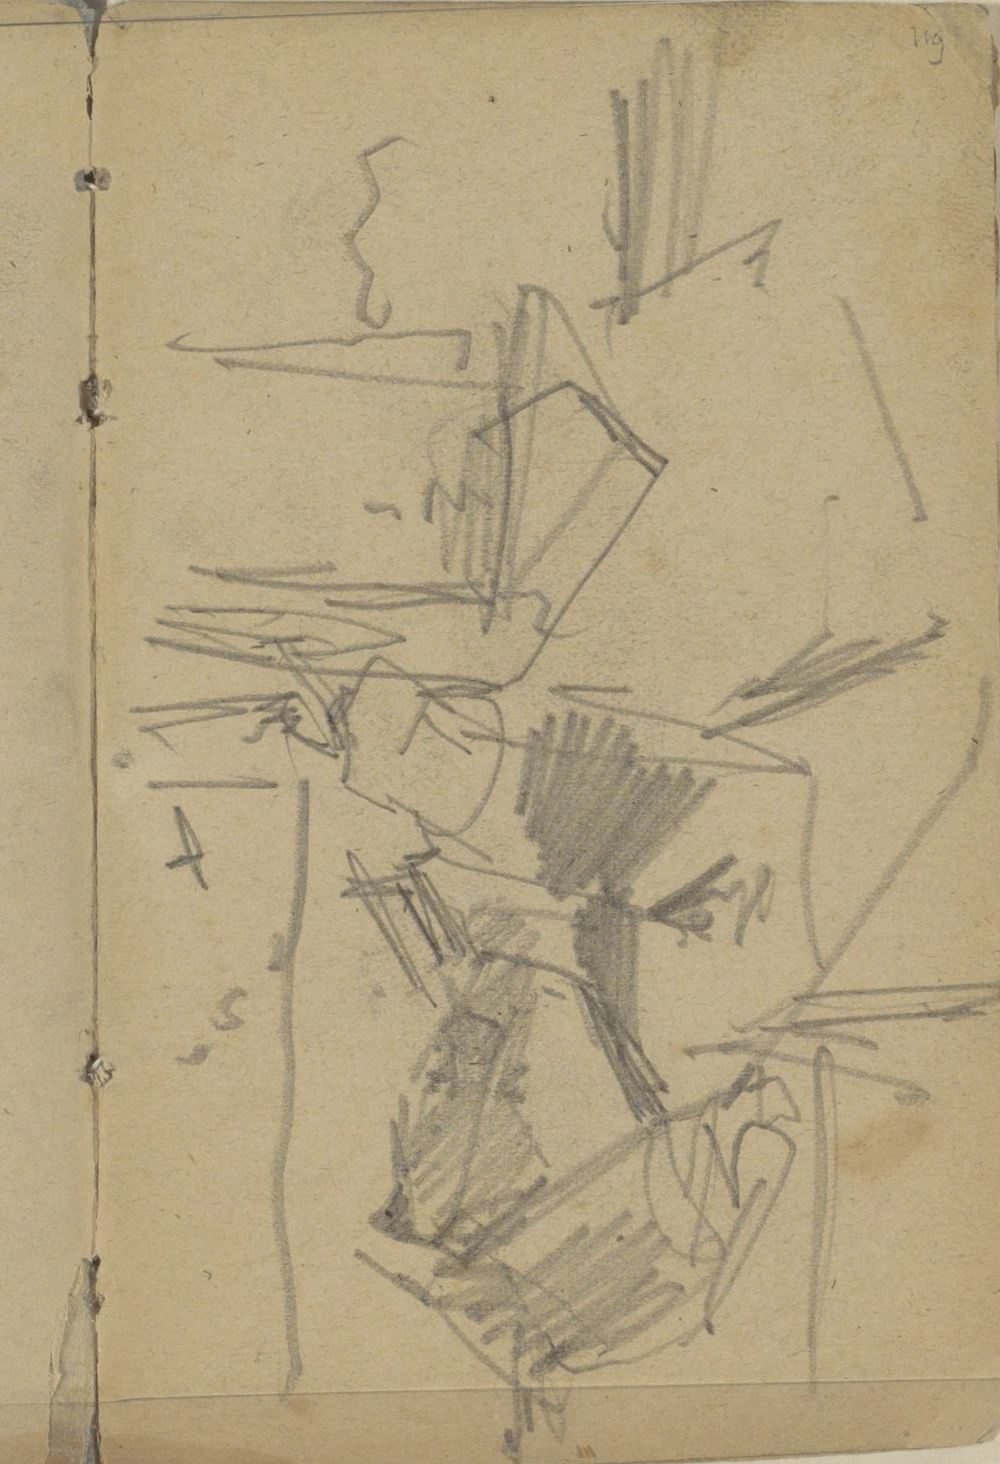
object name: sketchbook leaf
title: Figuur, mogelijk een meisje, aan een tafel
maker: george hendrik breitner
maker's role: draughtsman, painter, print maker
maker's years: 1857-1923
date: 1881-1883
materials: paper, pencil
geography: south holland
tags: writing-table, writing-desk, girl (child between toddler and youth)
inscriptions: kleurnotitie, handgeschreven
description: Figuur, mogelijk een meisje, aan een tafel. Ze schrijft of tekent. Pagina 119 uit een schetsboek met 70 bladen.